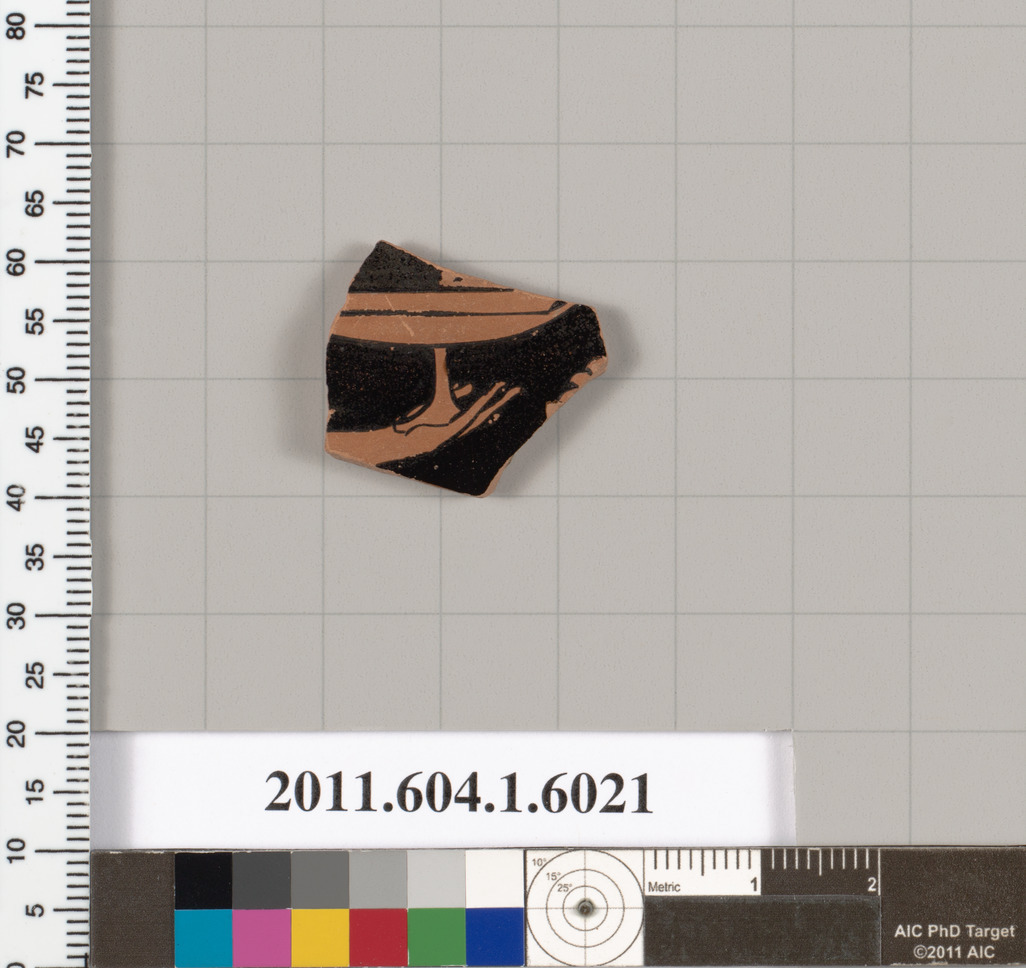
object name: kylix fragment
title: Terracotta fragment of a kylix (drinking cup)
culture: greek, attic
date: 510-500 BCE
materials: terracotta